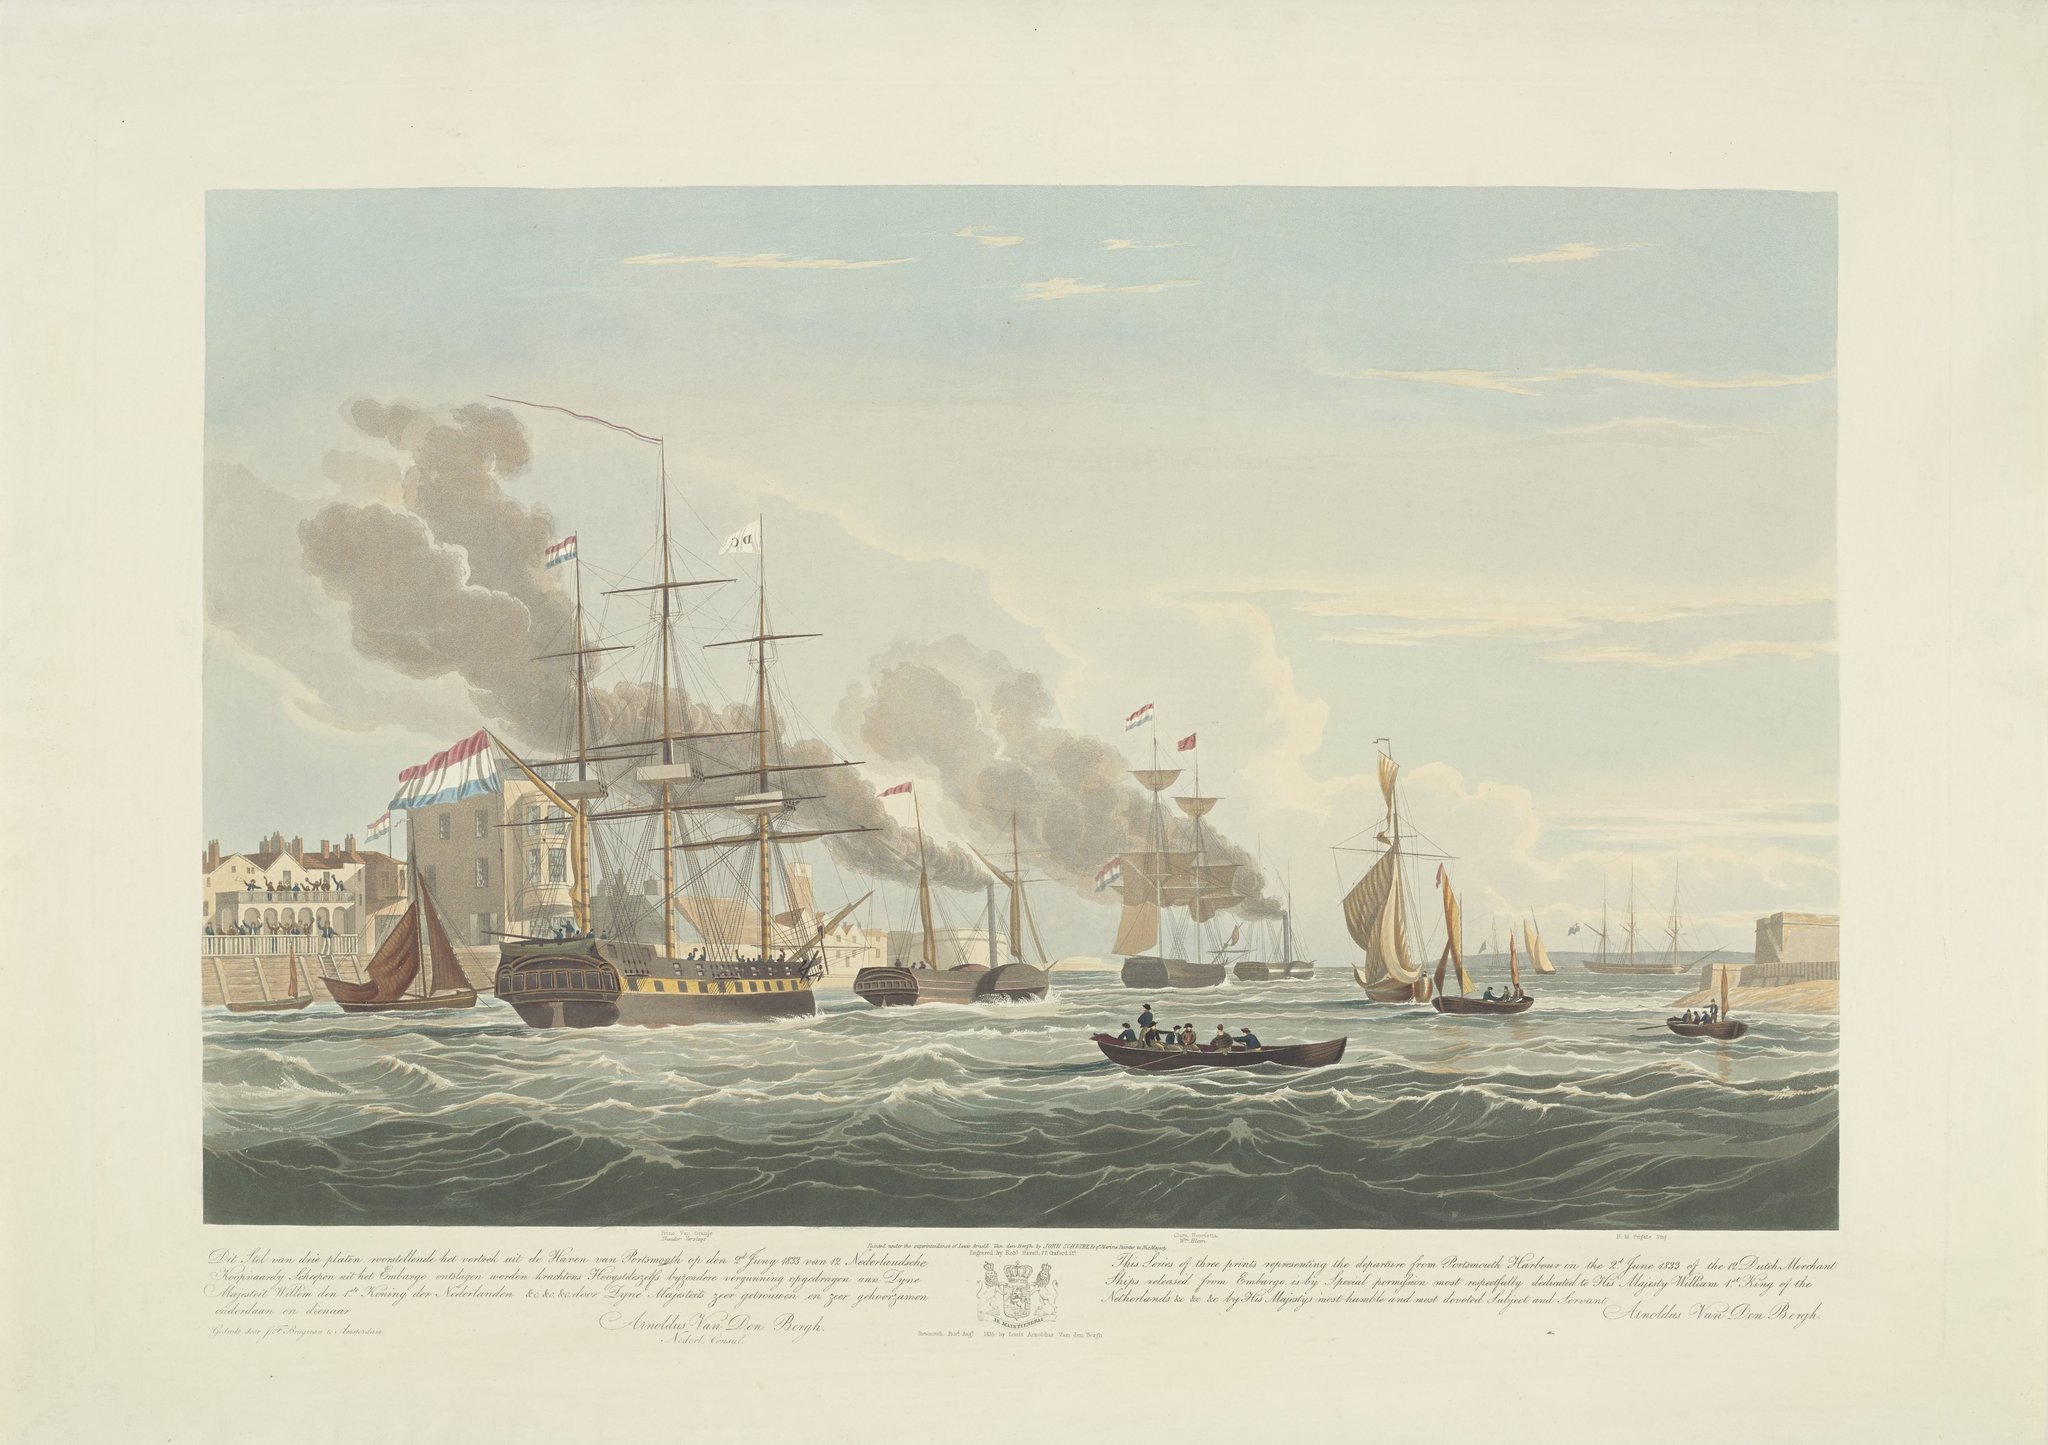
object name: print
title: Vertrek van twaalf Nederlandse koopvaardijschepen uit de haven van Portsmouth, 1833 (plaat 2)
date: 1808-1835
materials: paper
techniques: etching, hand coloring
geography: london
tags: harbour, sailing-ship, sailing-boat, merchant shipping, shipping trade, portsmouth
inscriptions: collector's mark: Lugt 2228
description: Het vertrek van de twaalf Nederlandse koopvaardijschepen uit de haven van Portsmouth, na de opheffing van het embargo, 2 juni 1833. Het Britse embargo was ingesteld ca. november 1832 om de Nederlanders te bewegen de Citadel van Antwerpen over te dragen aan België. Hierbij werden alle Nederlandse schepen in Britse havens aan de ketting gelegd. Tweede plaat in een serie van drie. Links het schip Prins van Oranje dat door een stoomboot wordt gesleept. Onderaan in de marge de namen van de schepen. Het wapen van koning Willem I onderaan centraal tussen de Nederlandse en Engelse titel en opdracht.